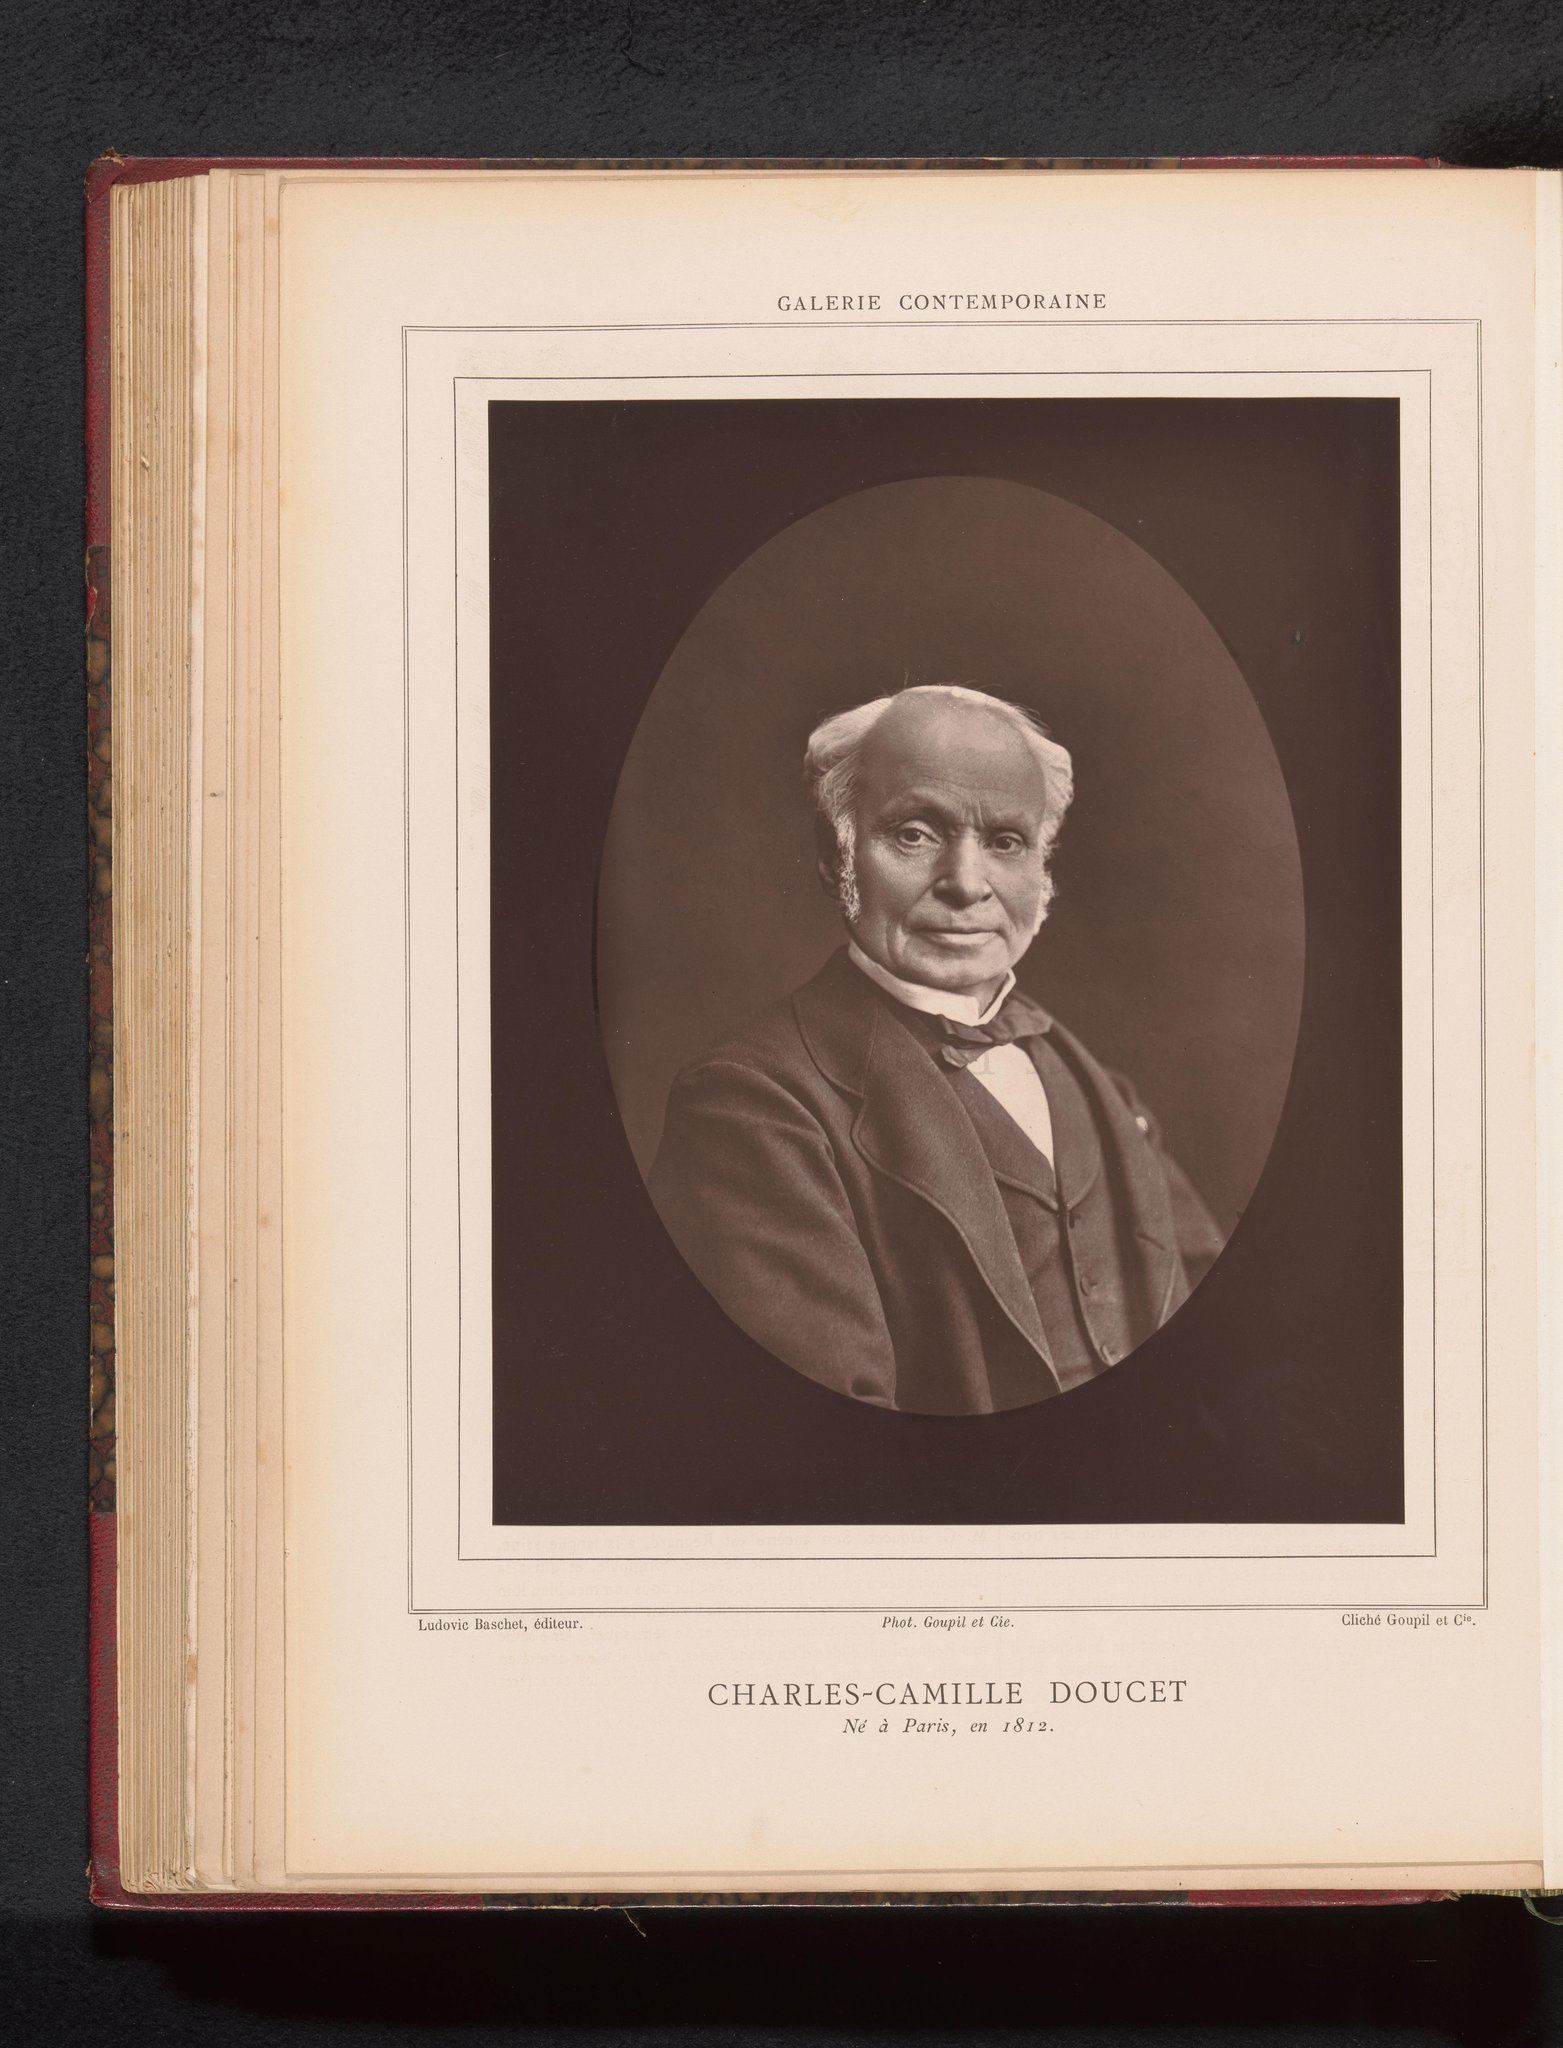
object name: photomechanical print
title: Portret van Charles-Camille Doucet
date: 1867-1880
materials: paper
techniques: woodburytype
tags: paris, adult man, historical persons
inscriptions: inscription: ‘Galerie Contemporaine/ Ludovic Baschet, éditeur./ Né a Paris, en 1812.’